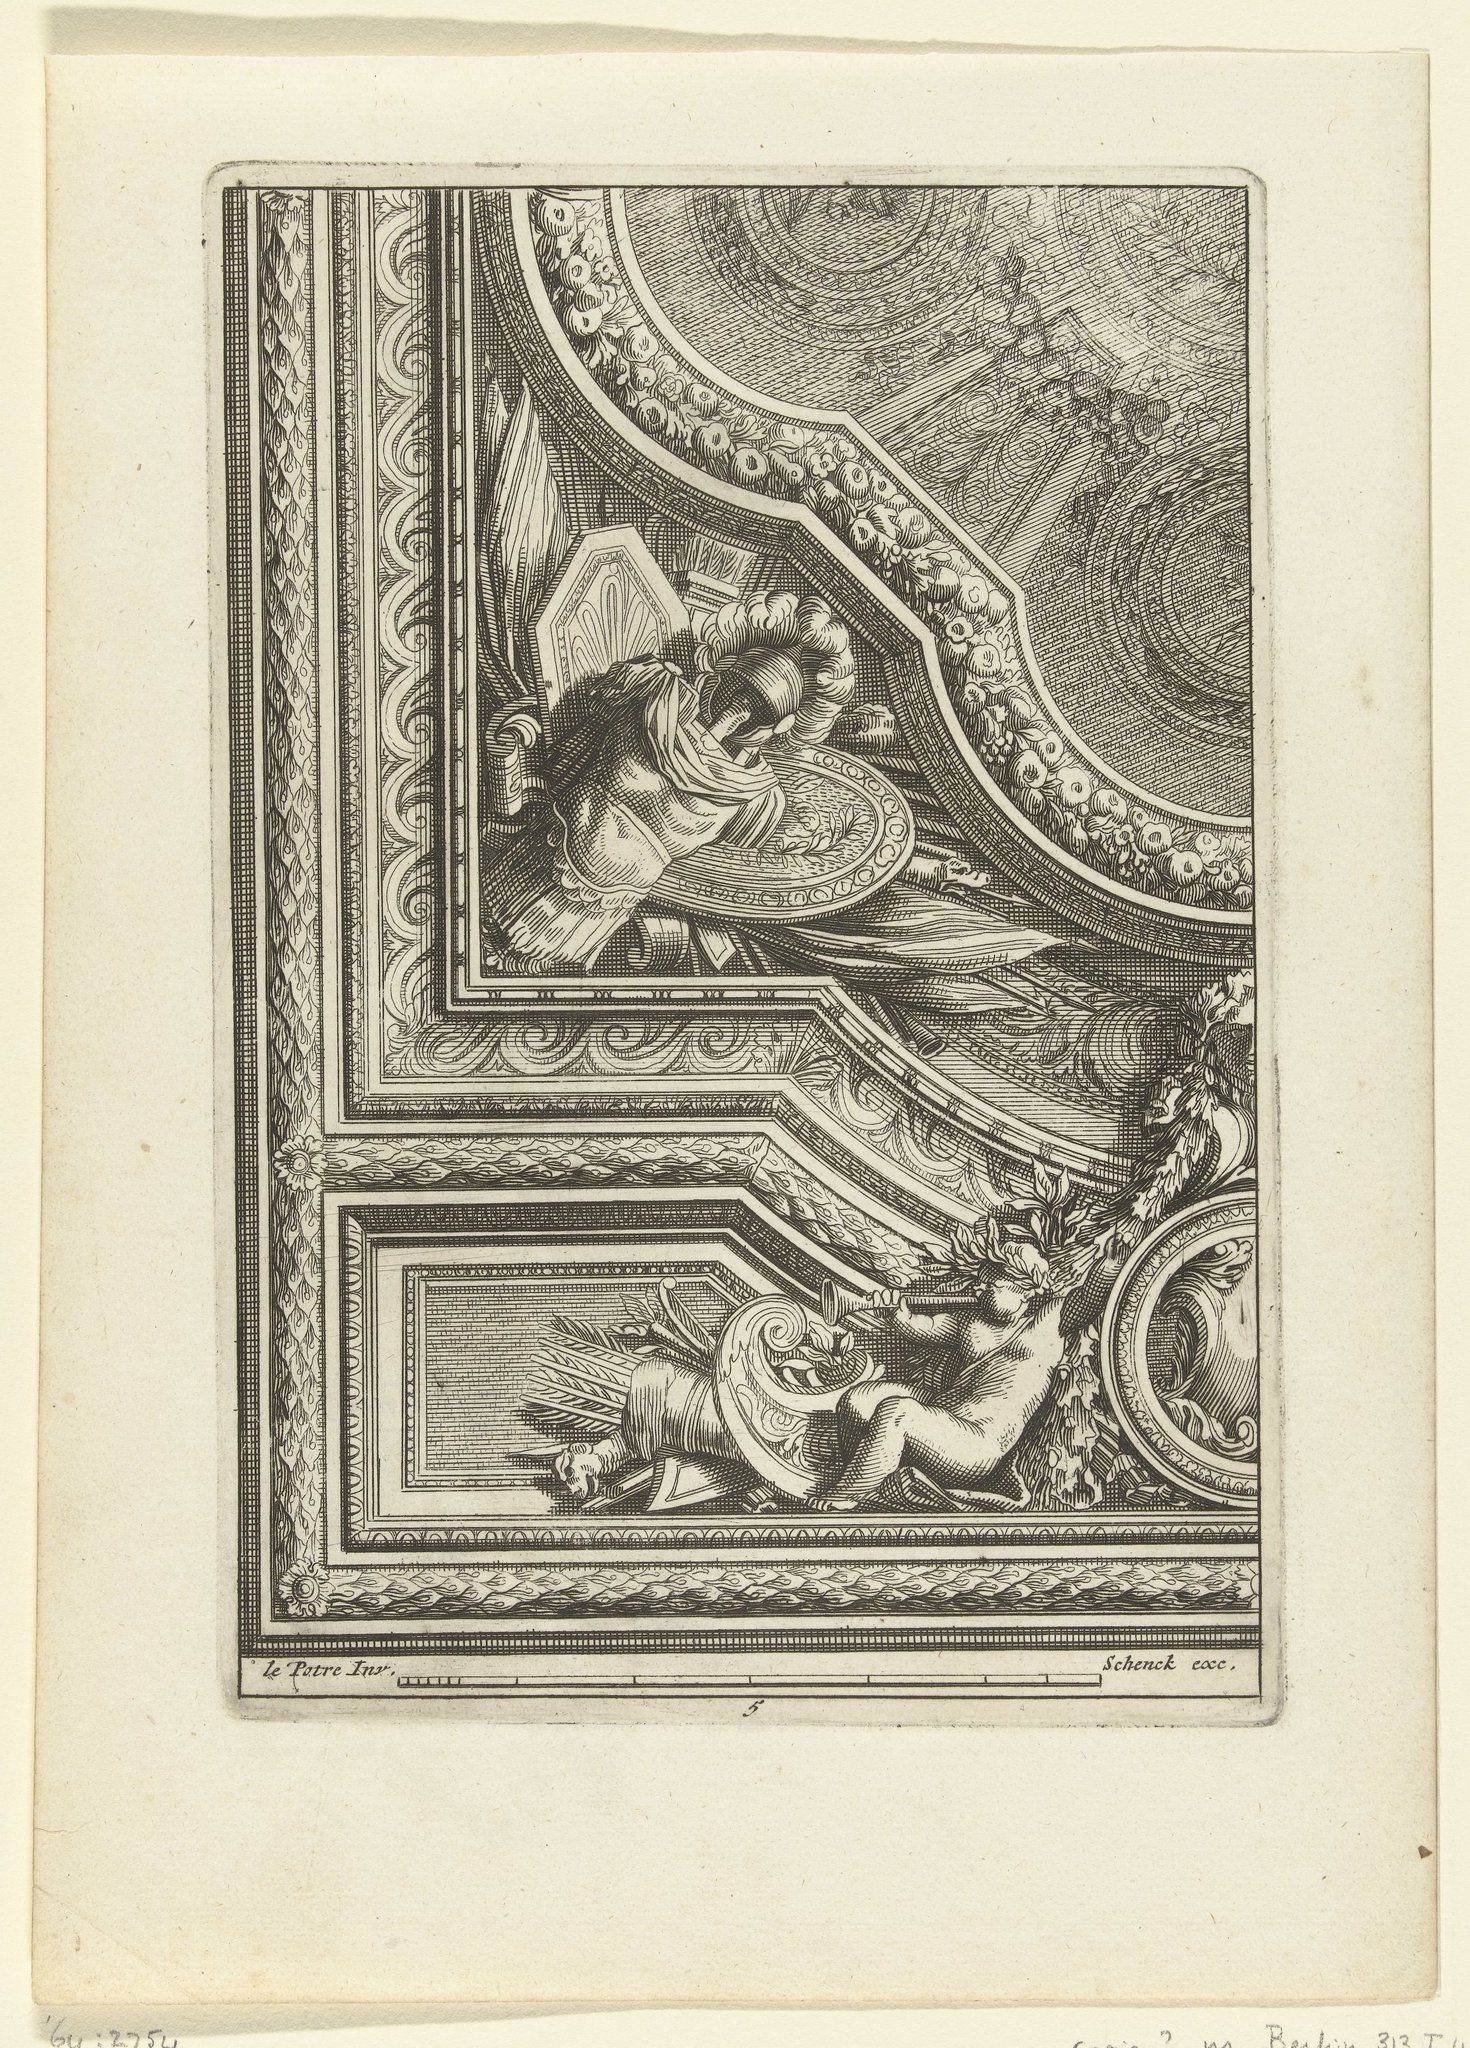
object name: ornament print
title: Plafonds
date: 1655-1657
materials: paper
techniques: etching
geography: france